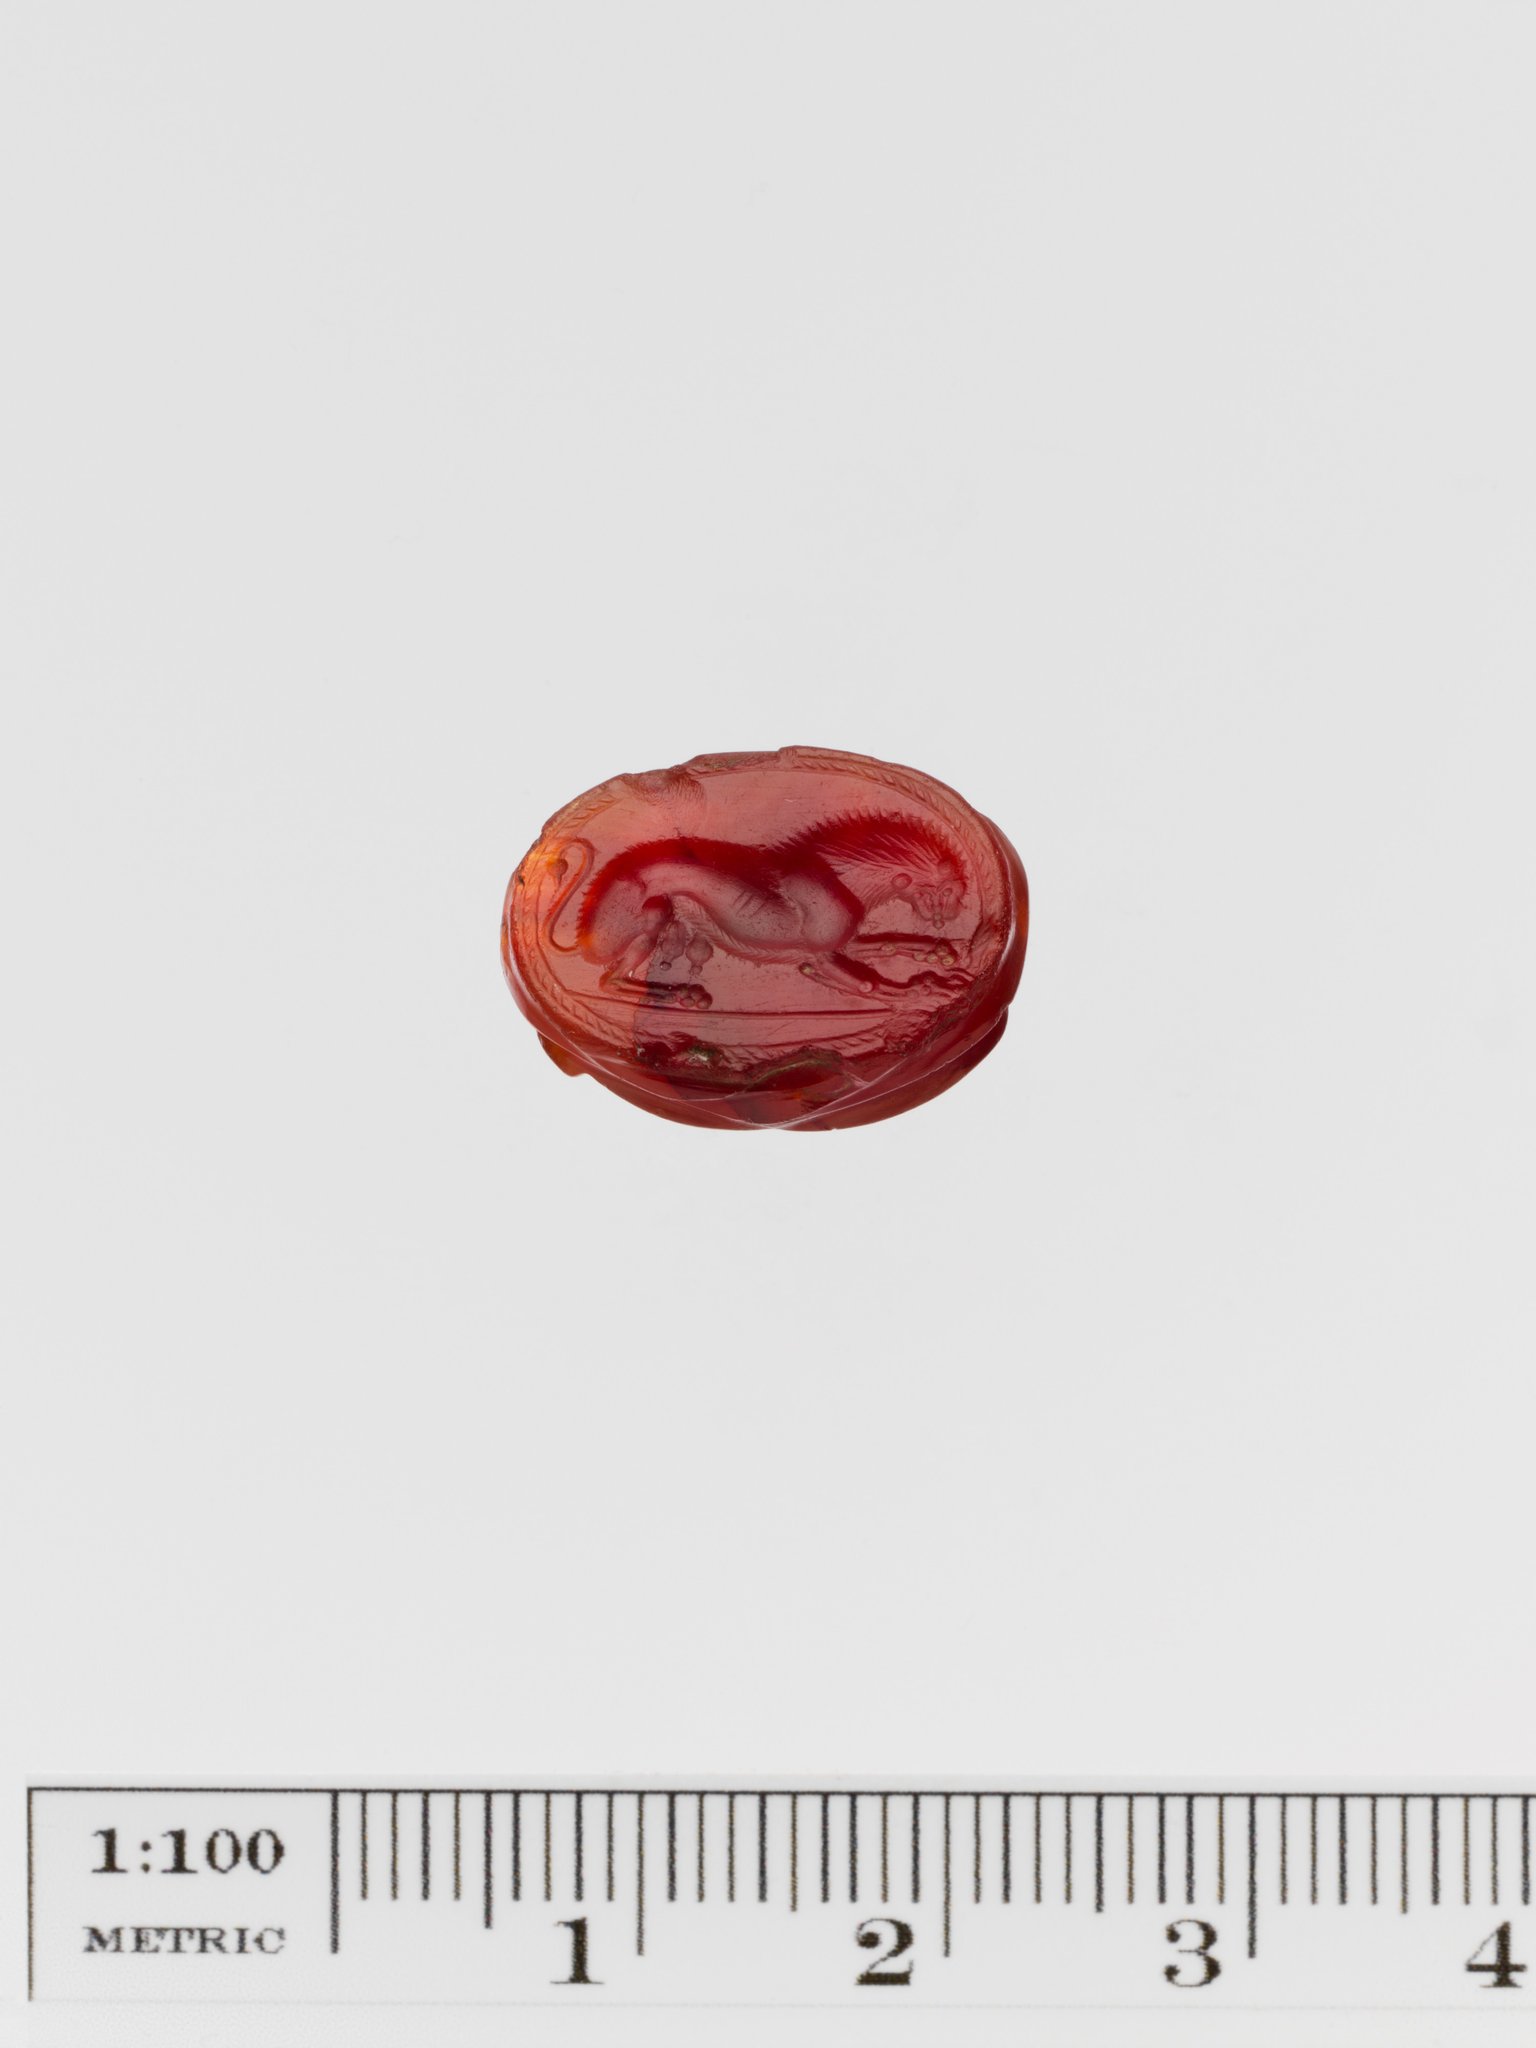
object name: scarab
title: Carnelian scarab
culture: greek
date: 500-401 BCE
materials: gemstone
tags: animals,scarabs